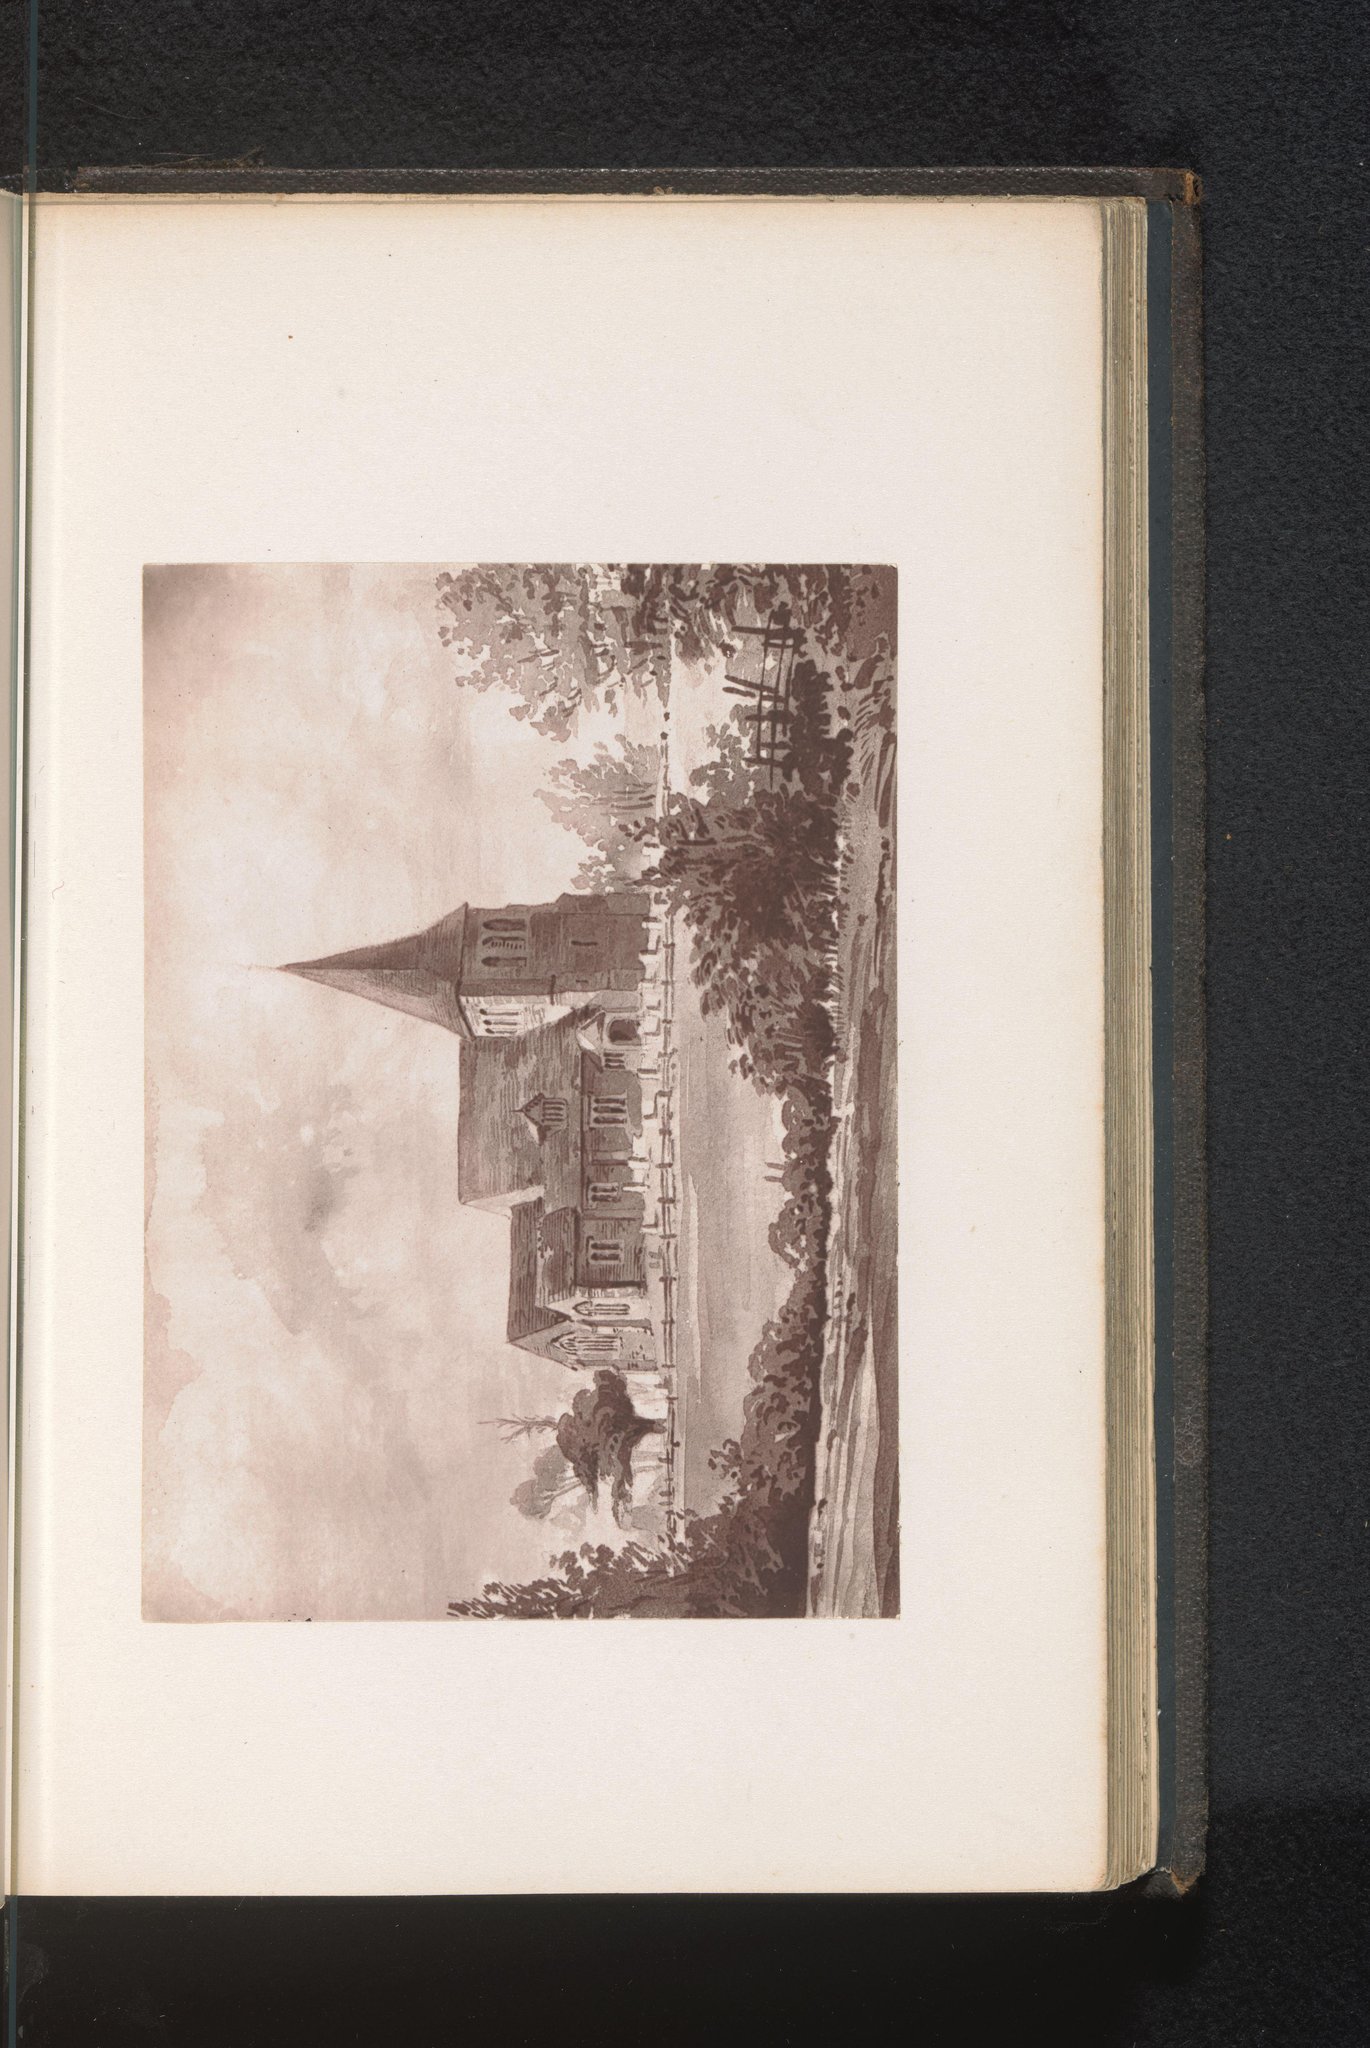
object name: photomechanical print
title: Fotoreproductie van een schildering, voorstellende een gezicht op All Saints Church te Herstmonceux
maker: Anonymous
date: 1866-1876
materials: paper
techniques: woodburytype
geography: herstmonceux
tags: church (exterior), façade (of house or building)